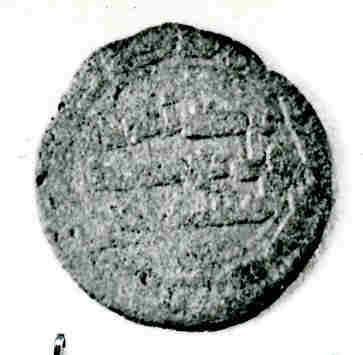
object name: coin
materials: copper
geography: iran